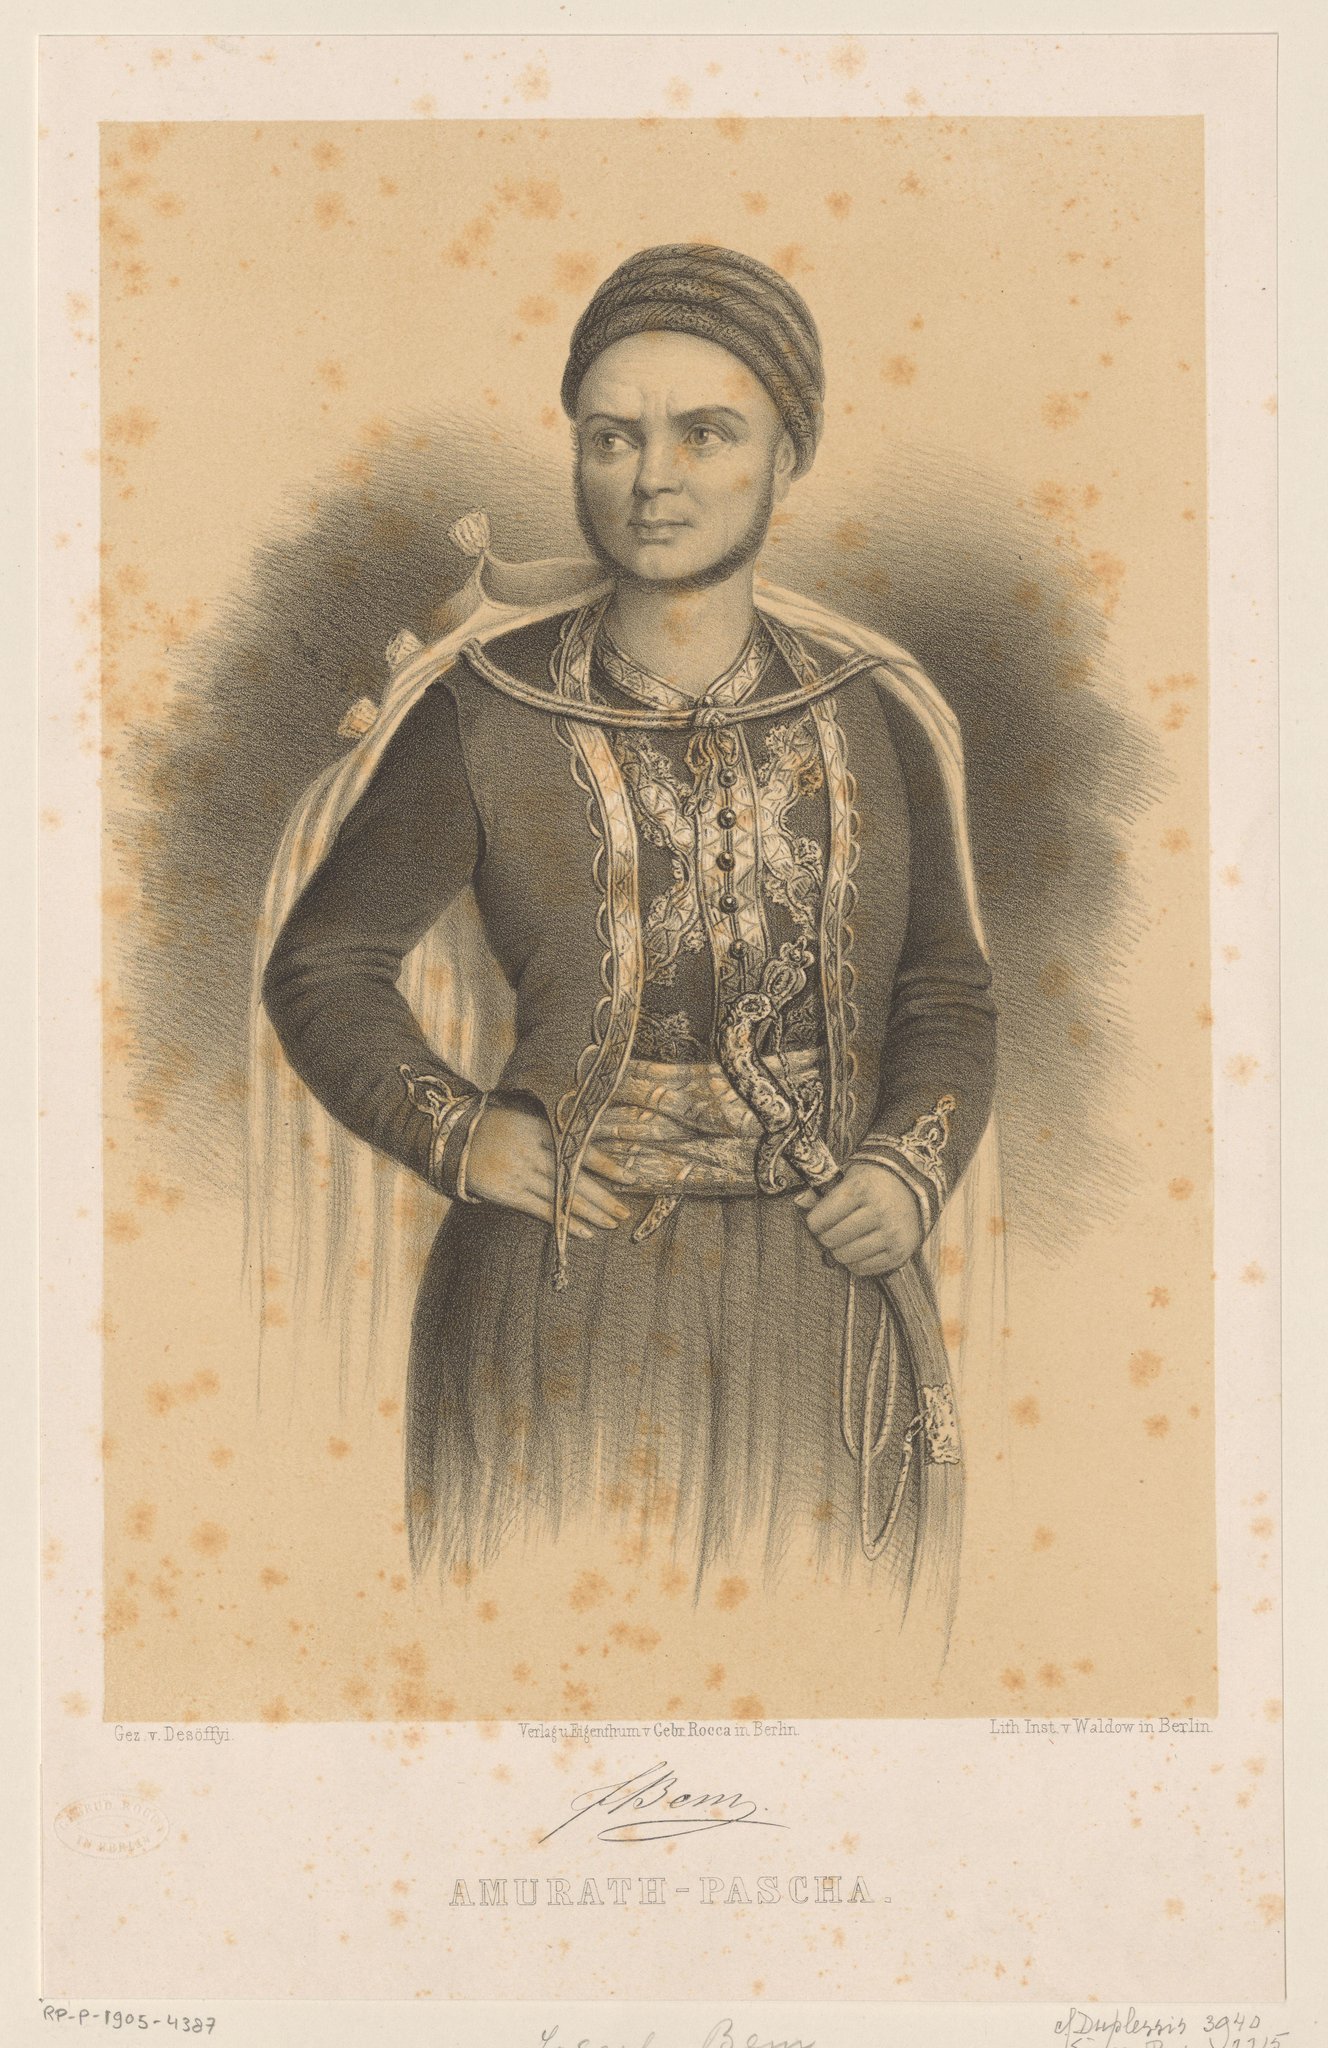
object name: print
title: Portret van Józef Bem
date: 1849-1874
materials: paper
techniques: intaglio, lithograph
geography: berlin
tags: historical persons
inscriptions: workshop stamp: Lugt 2141c, collector's mark: Lugt 2228